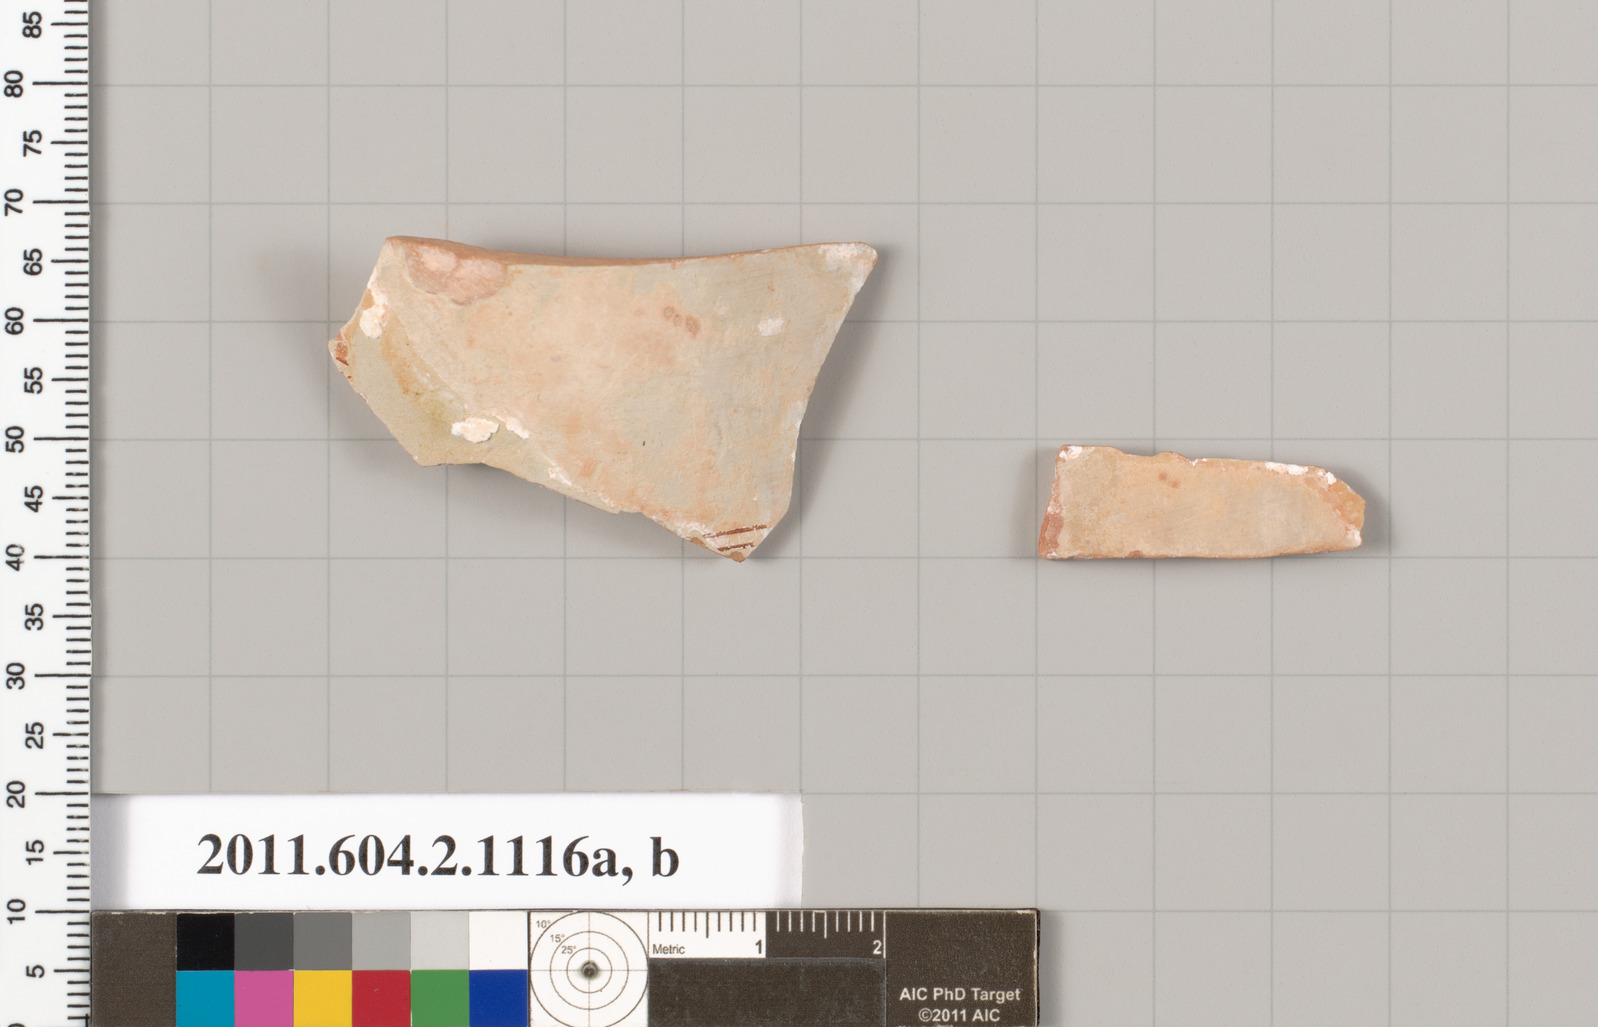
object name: lekythos fragment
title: Terracotta fragments of a lekythos (oil flask)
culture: greek, attic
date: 475-451 BCE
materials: terracotta